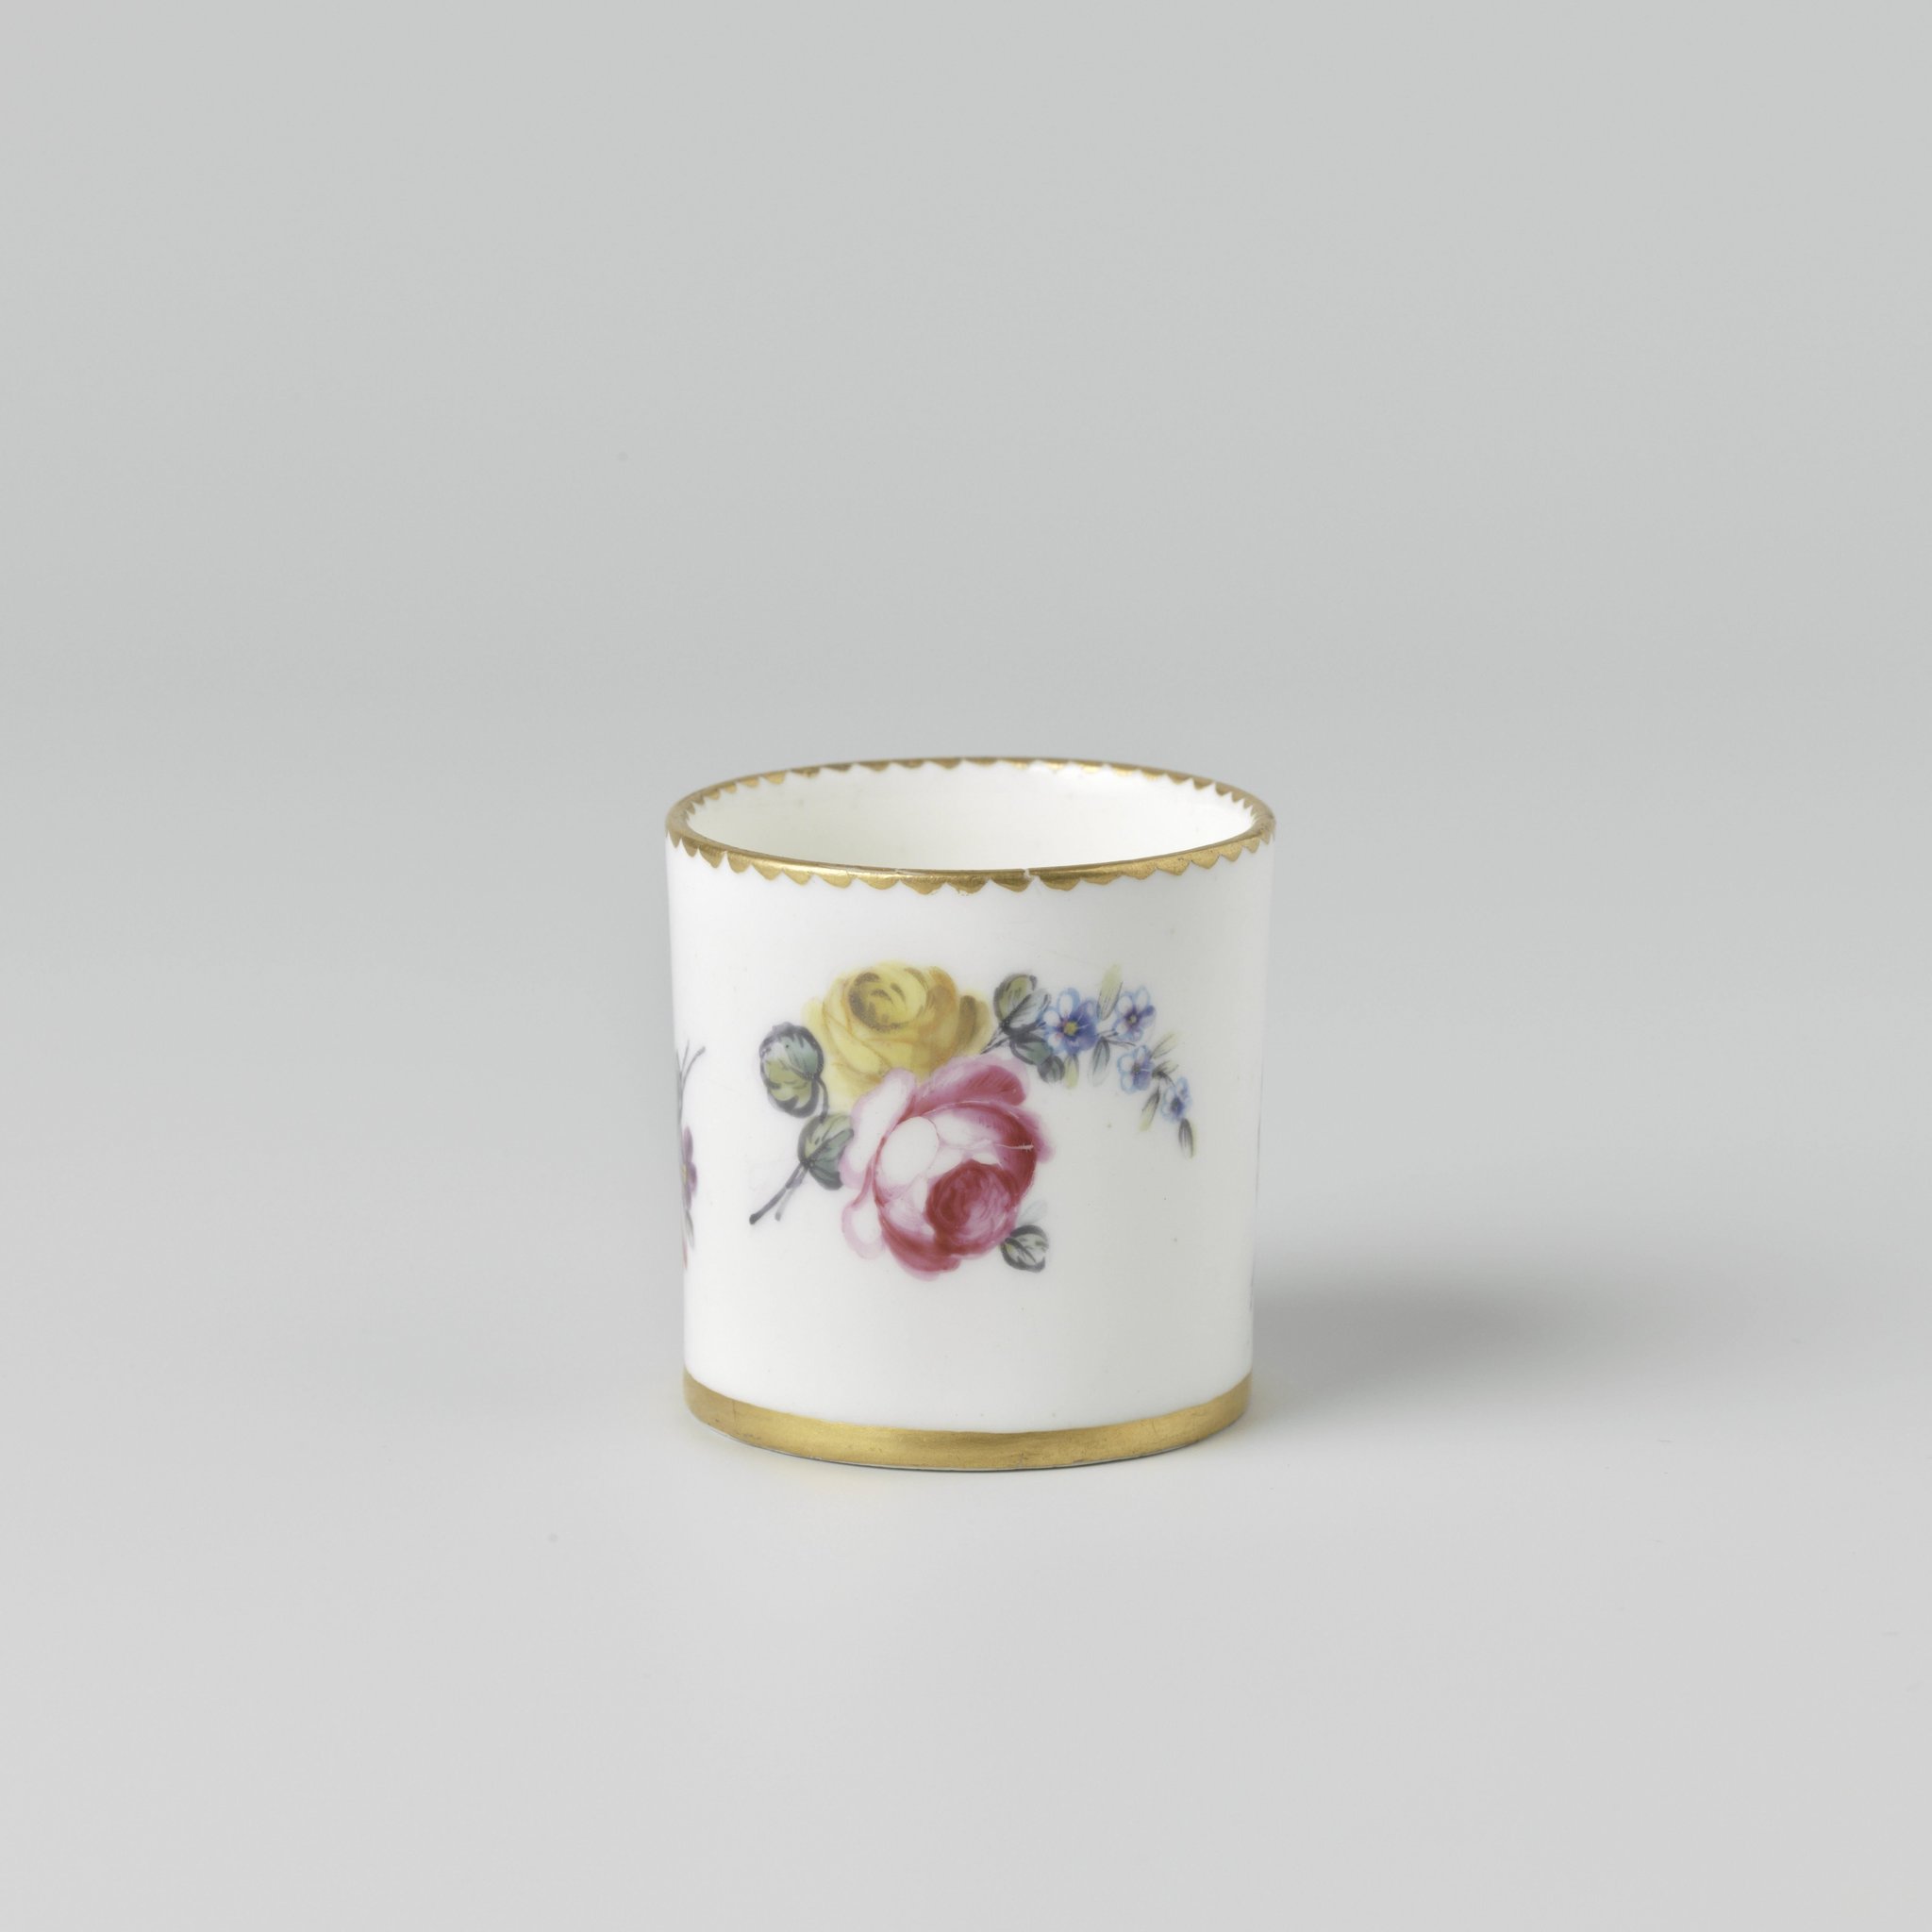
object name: cup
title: Cup with bouquets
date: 1767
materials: glaze, gold, paint, porcelain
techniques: firing, forming, gilding, turning, vitrification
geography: sèvres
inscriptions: mark: ‘dubbele L/ jaarnummer O/ A’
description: Kop van porselein met een cilindrische wand, beschilderd op het glazuur in blauw, rood, roze, groen, geel, paars, zwart en goud. De buitenwand is versierd met verschillende boeketten en strooibloemen. Boven de voet een gouden lijn en op de rand een gouden band van halve bollen. Gemerkt op de onderzijde met de dubbele L met jaarletter O, waaronder een A.